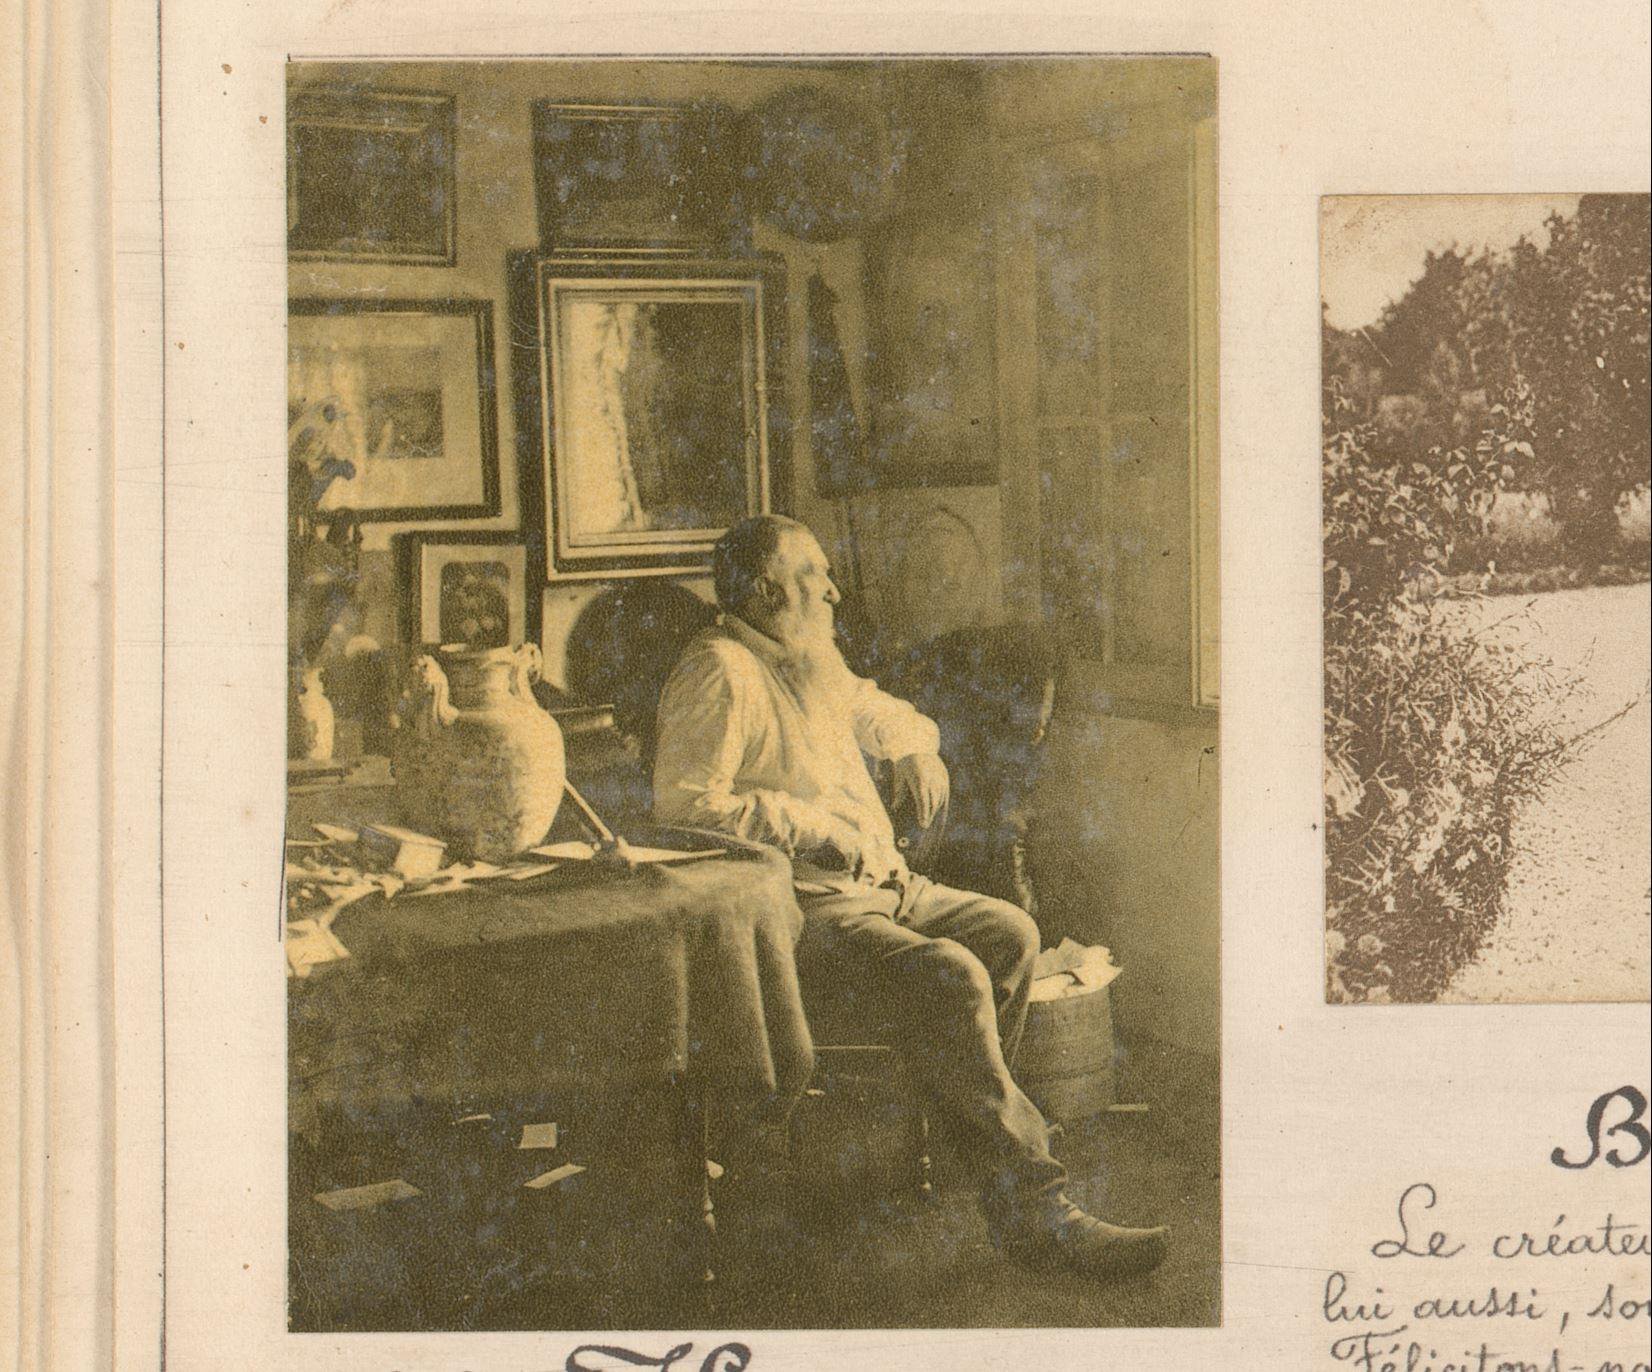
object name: album leaf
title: Alphonse Karr (en 1889)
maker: Anonymous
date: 1889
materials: paper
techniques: rotogravure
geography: france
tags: paris, alphonse karr, writer, poet, author, france